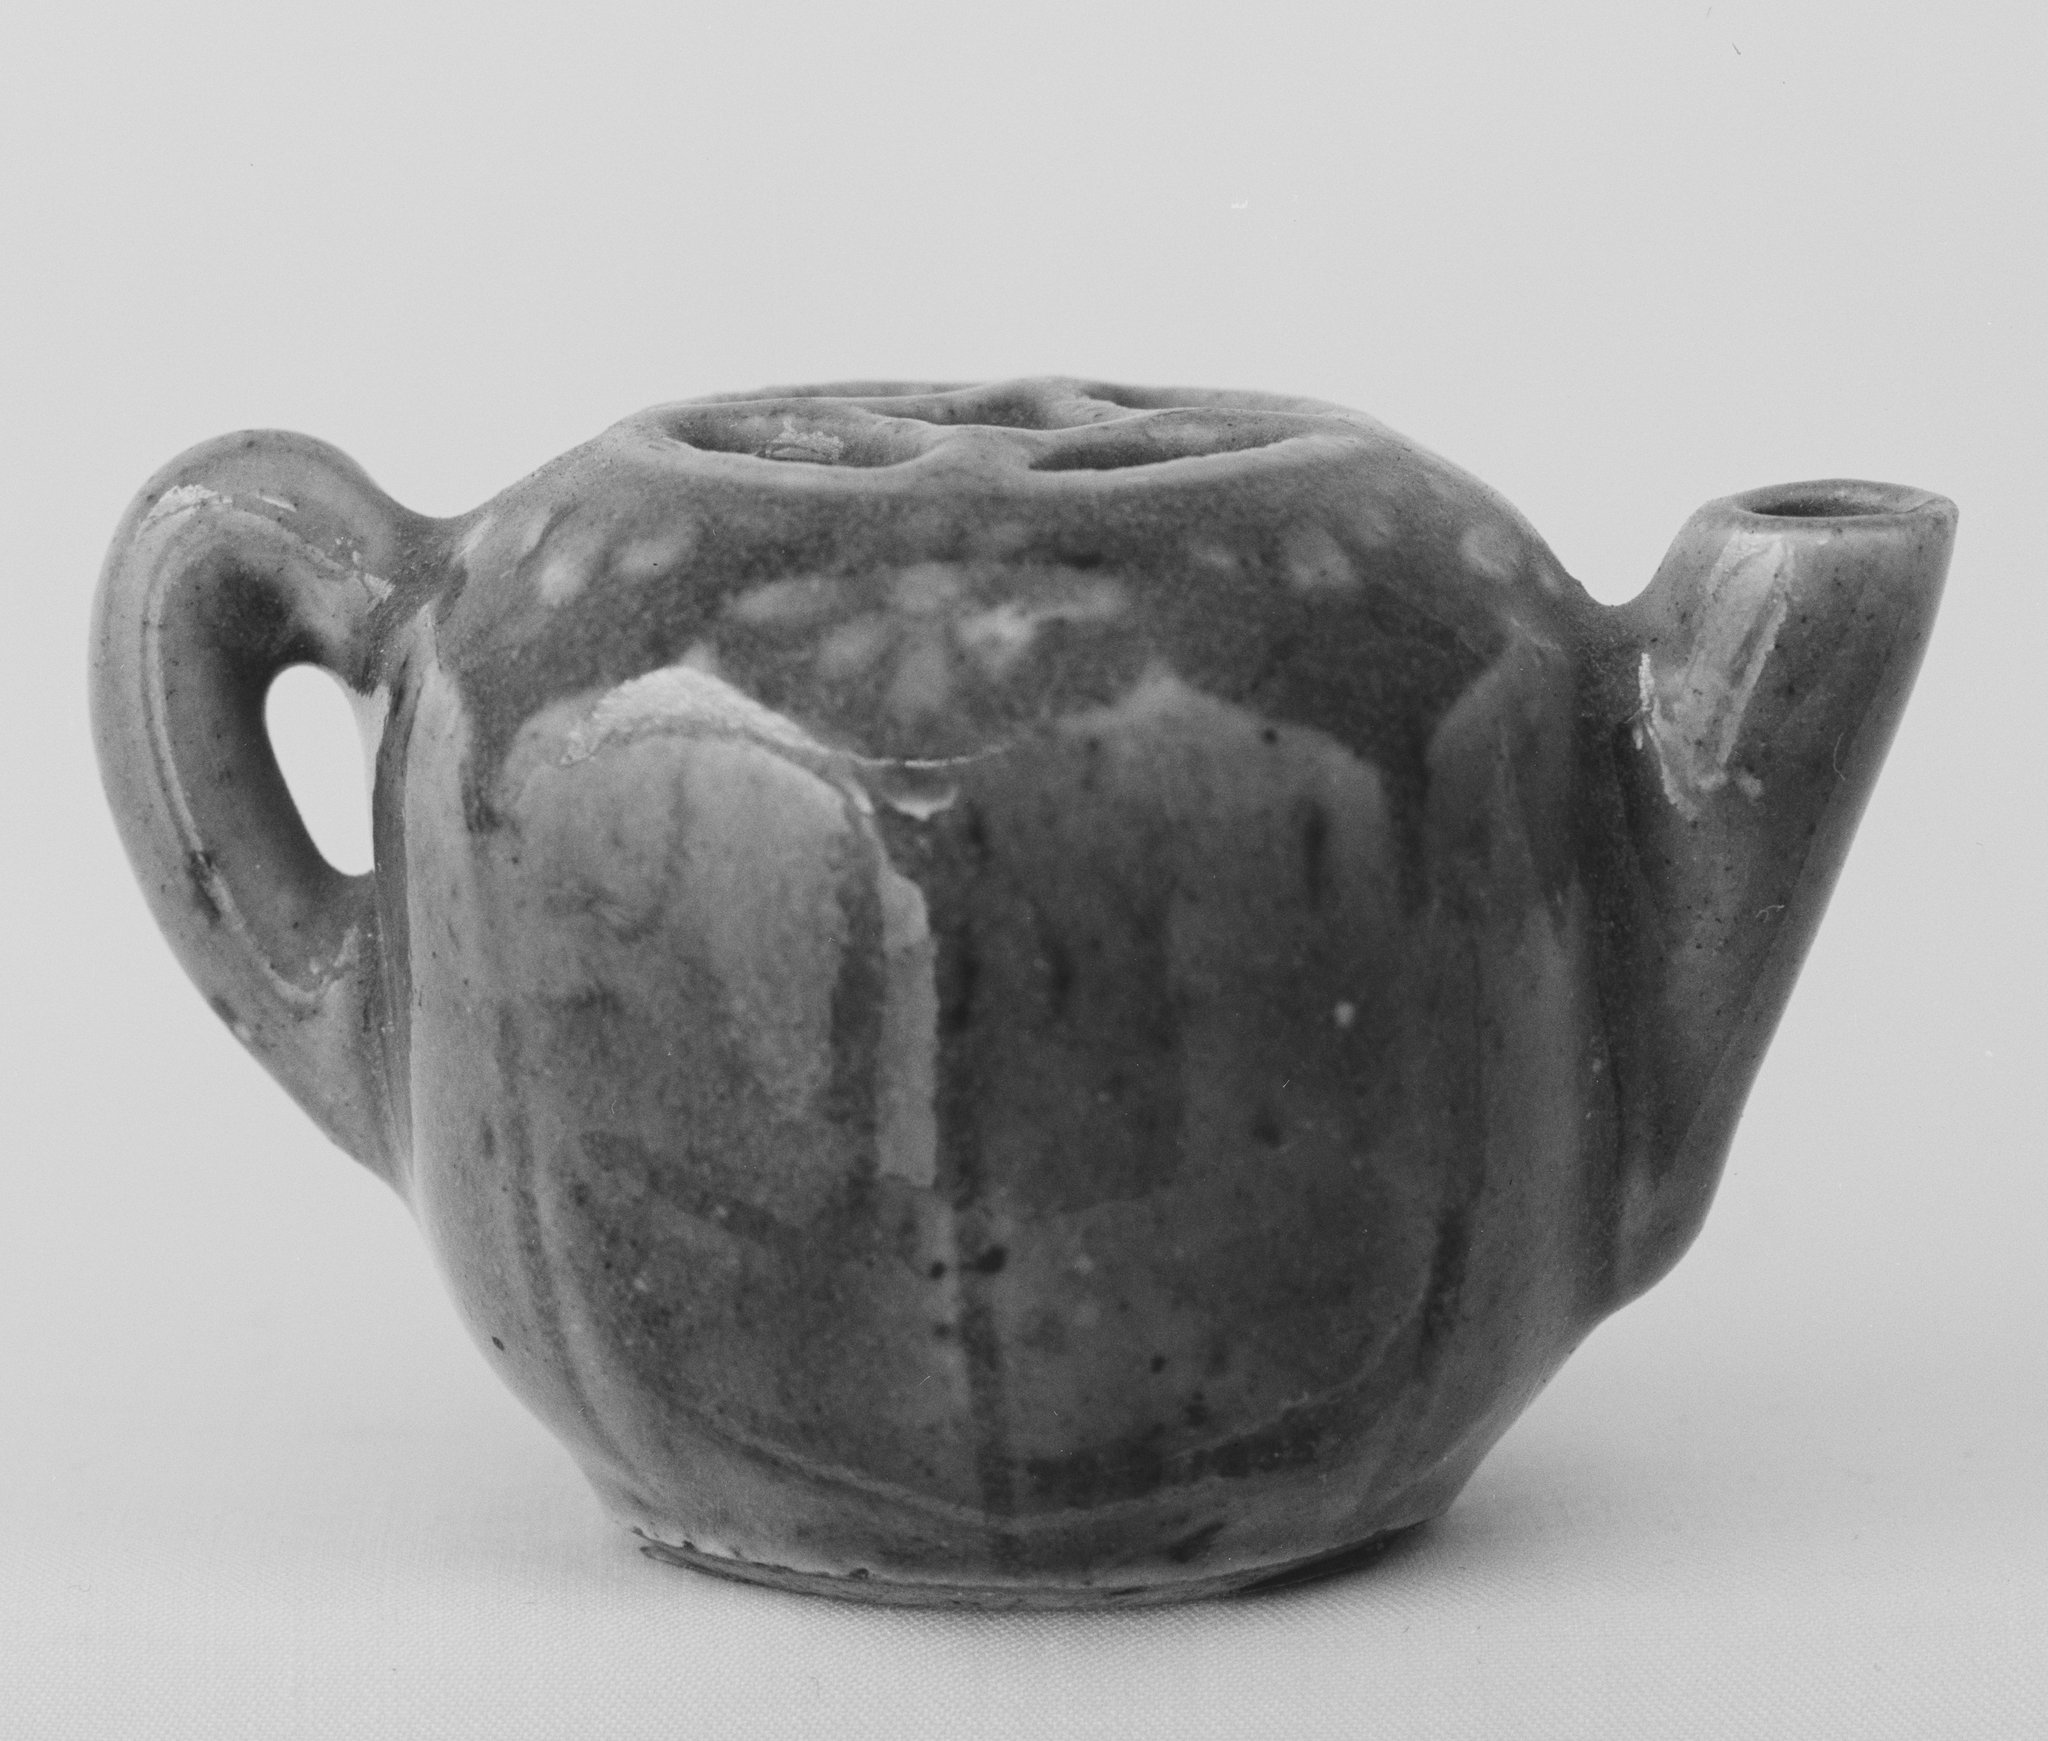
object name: water dropper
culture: chinese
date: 1701-1800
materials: glaze, porcelain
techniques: relief